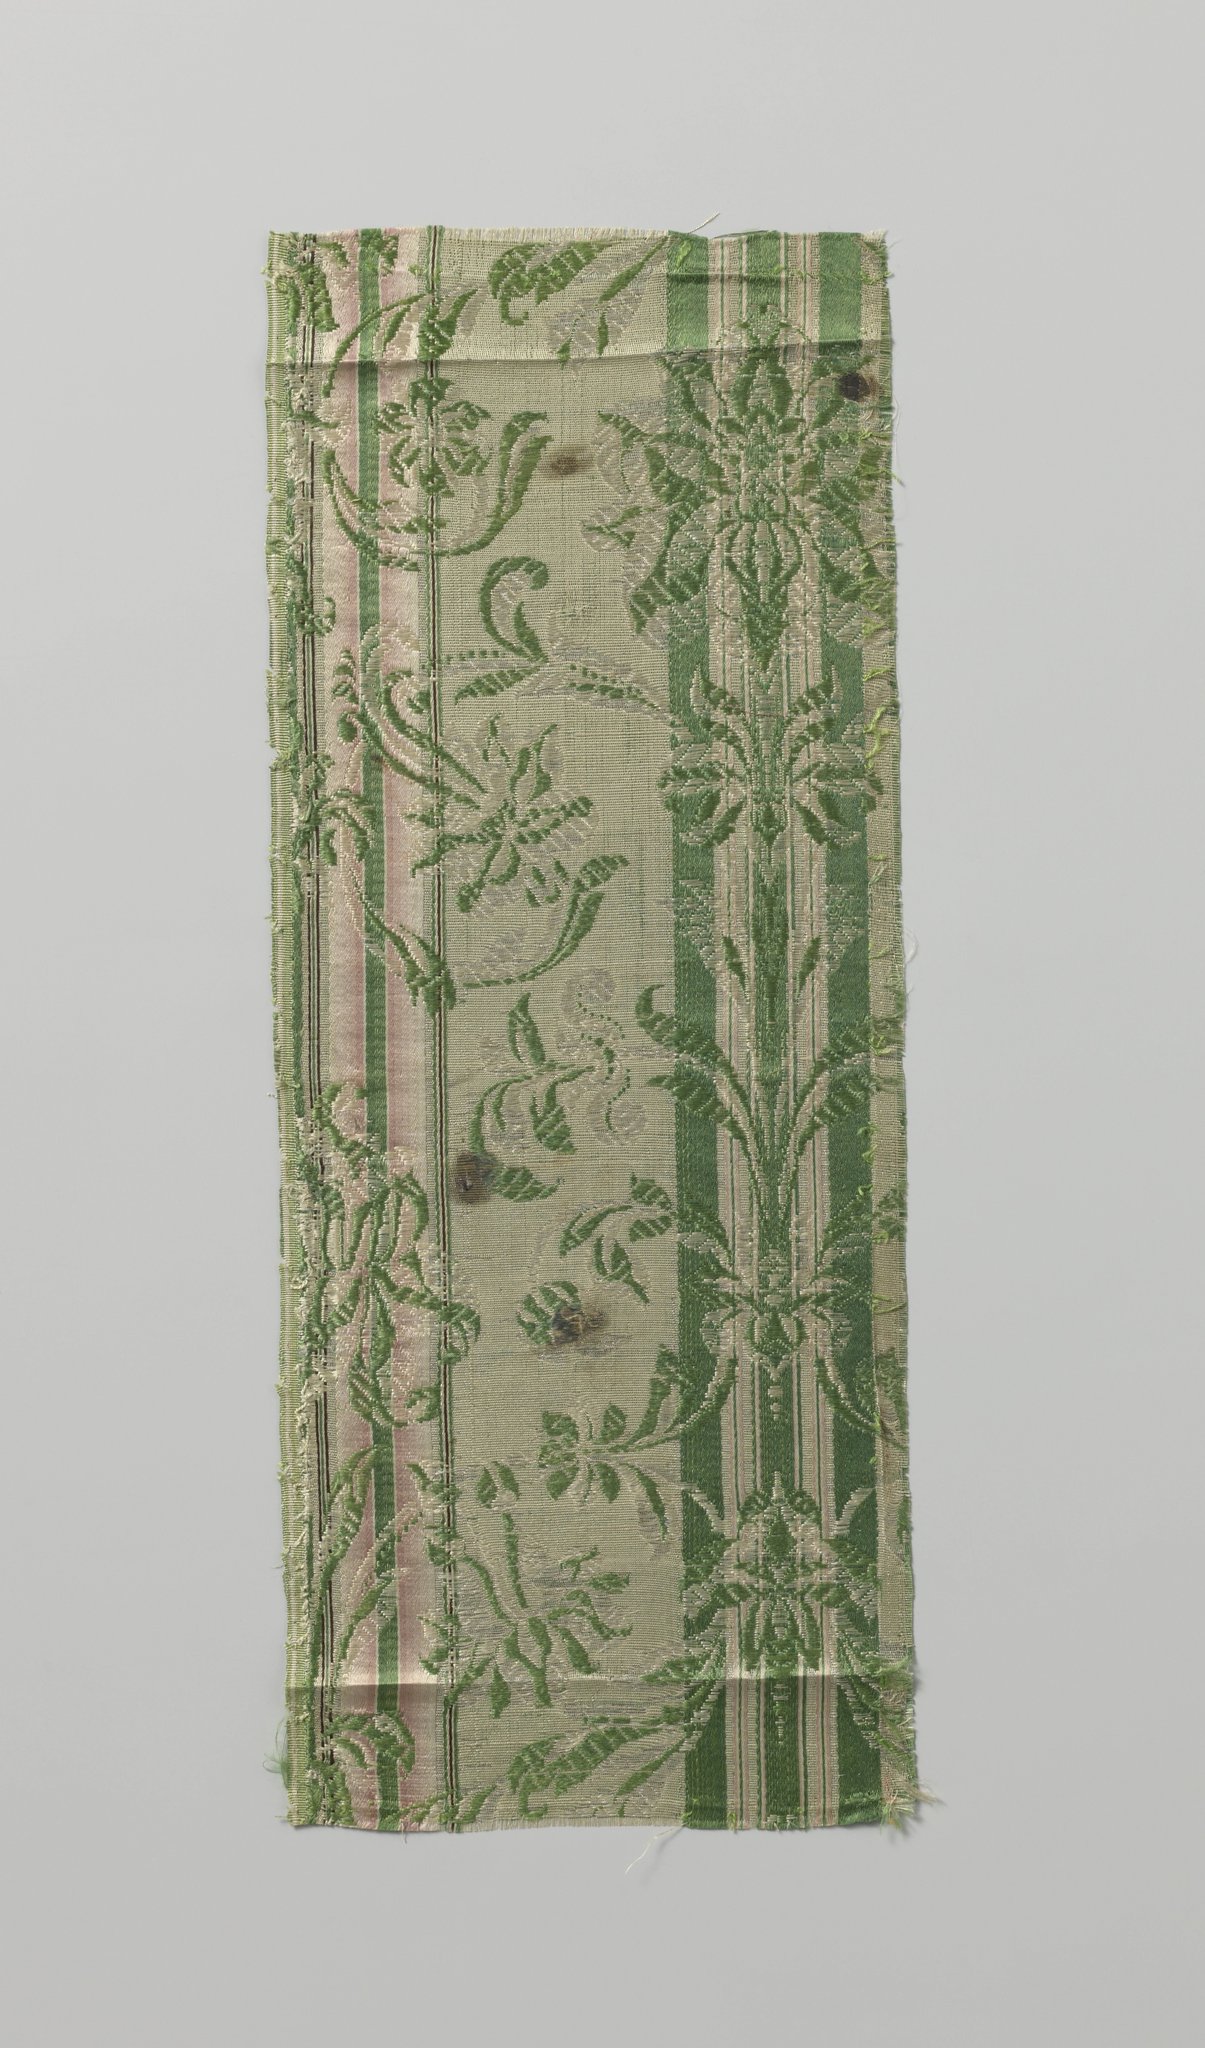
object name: zijdesatijn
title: Fragment zijdeweefsel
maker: Anonymous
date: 1700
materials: silk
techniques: liseré, satin binding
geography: netherlands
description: Fragment zijdeweefsel met een gestreept patroon van lichtgroen, donkergroen, roze en witte strepen waarover bloemen en ranken in groen en wit.